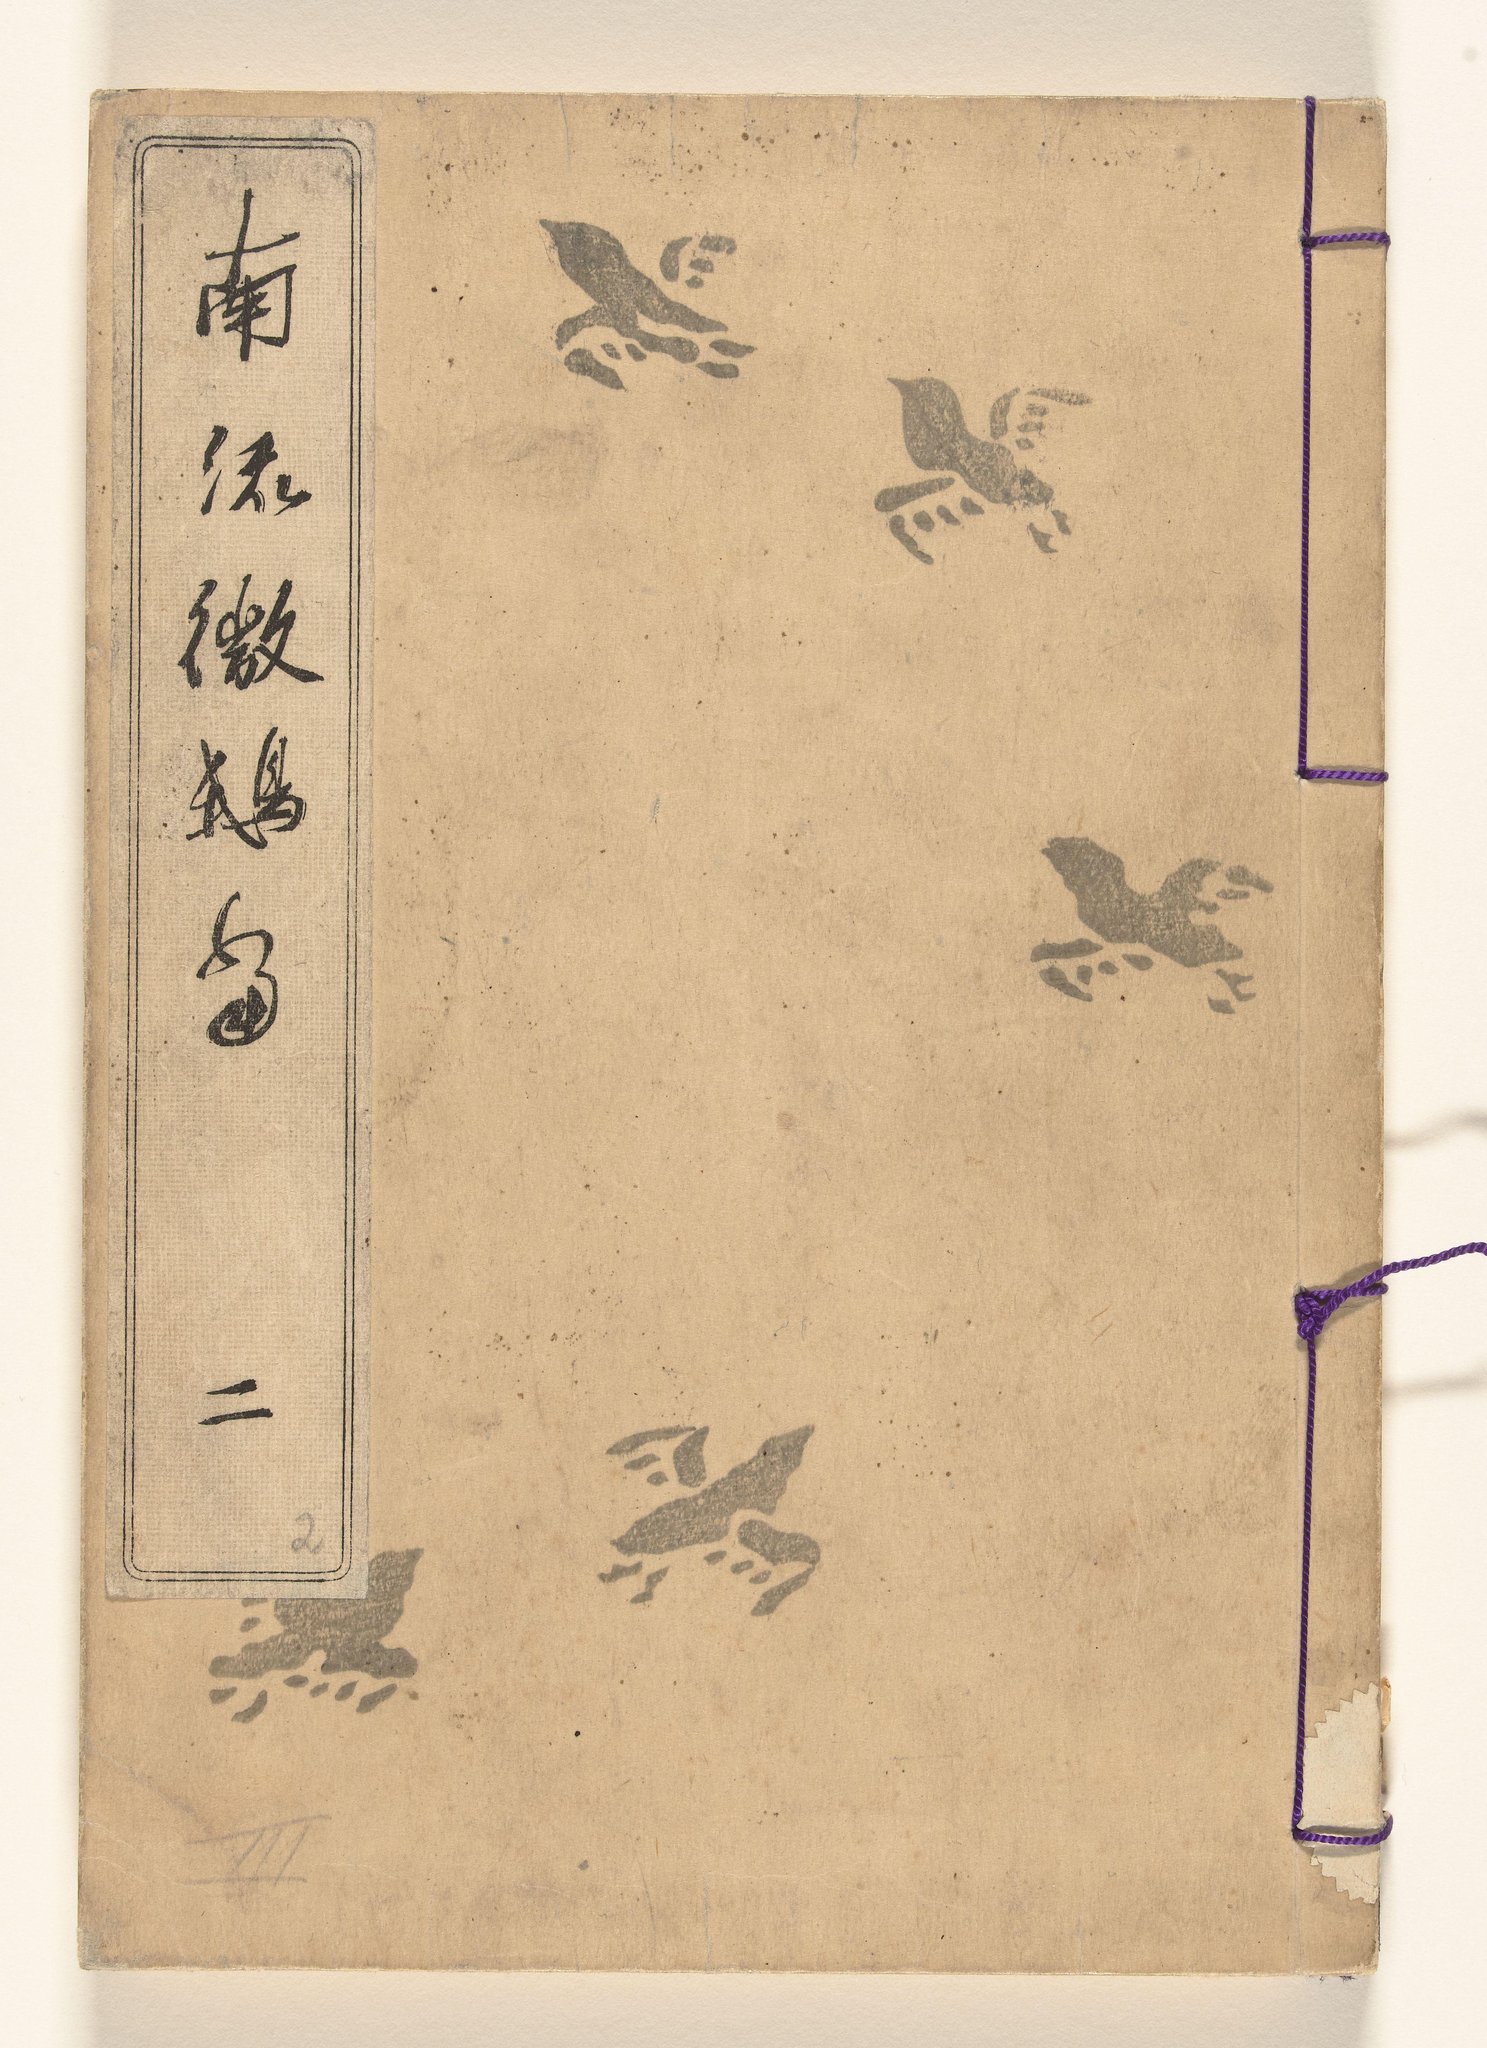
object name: book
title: Narumi stofpatronen, deel twee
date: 1883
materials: paper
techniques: woodcut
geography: nagoya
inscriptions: collector's mark: ‘Rijksschool voor kunstnijverheid’ Lugt 3937